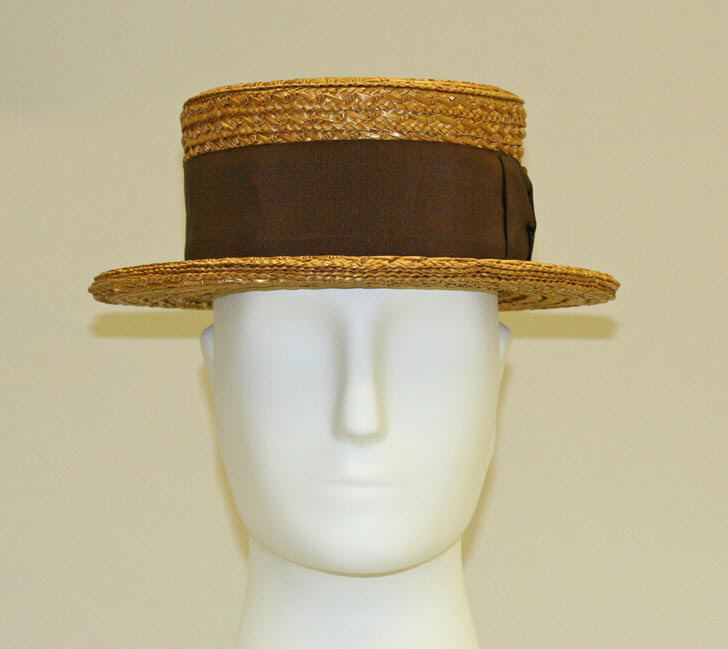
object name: sailor hat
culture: american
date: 1890-1899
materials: silk, fiber